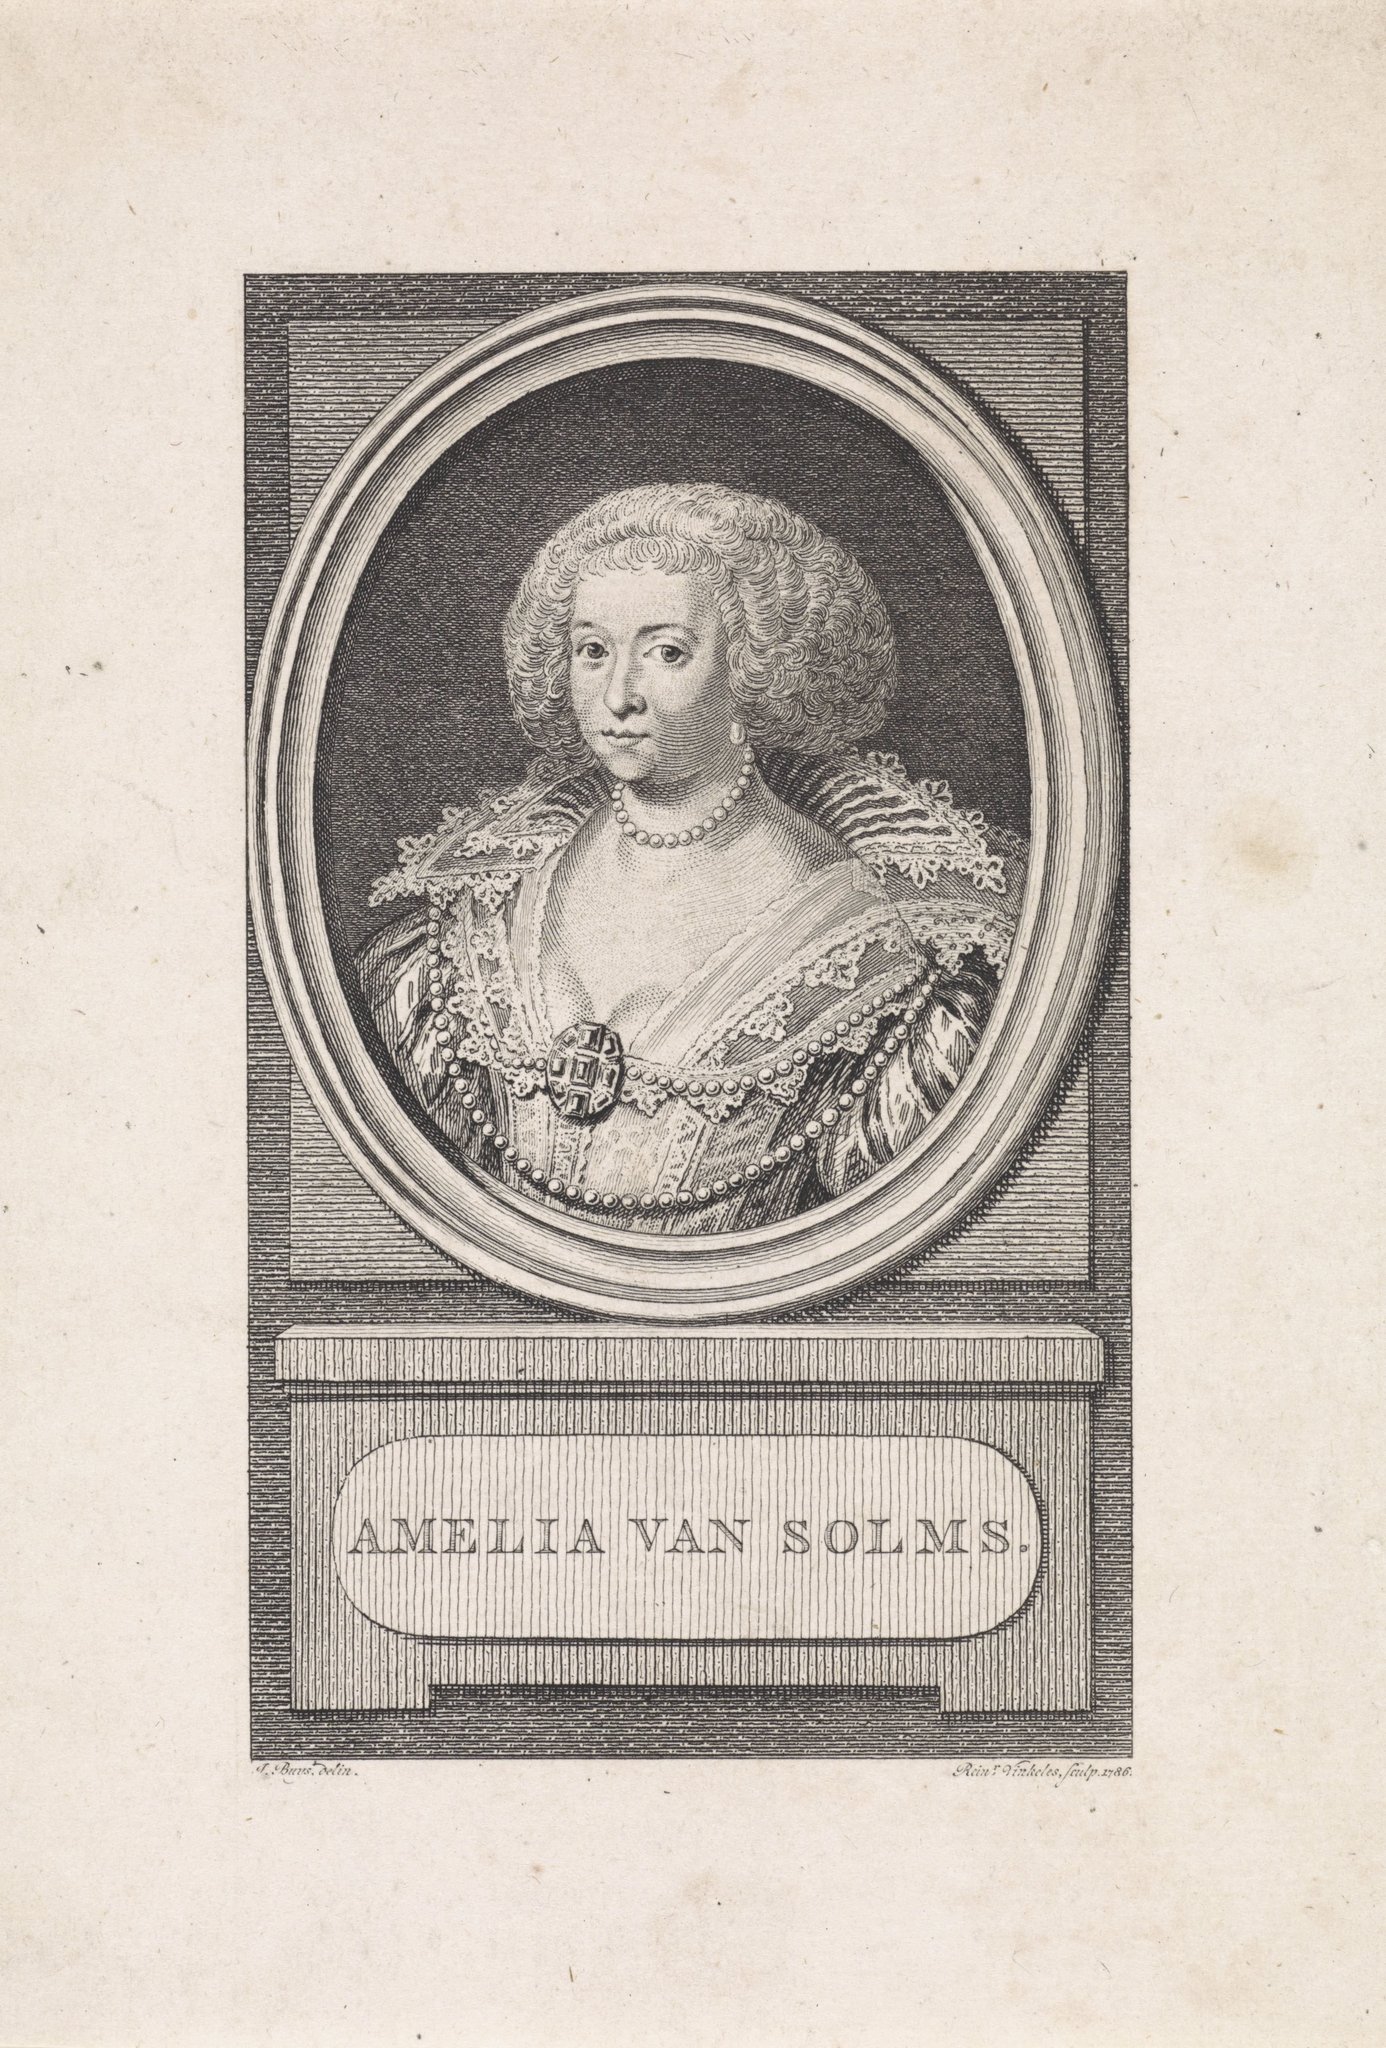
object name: print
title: Portret van Amalia van Solms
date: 1786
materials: paper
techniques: engraving, etching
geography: amsterdam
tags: the hague, amalia of solms-braunfels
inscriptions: collector's mark: Lugt 2228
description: Andere staat prent gebruikt als boekillustratie in: Kok, Jacobus. Vaderlandsch woordenboek : met kaarten, plaaten en pourtraitten. Amsterdam: Johannes Allart, 1785-1796. Deel III.